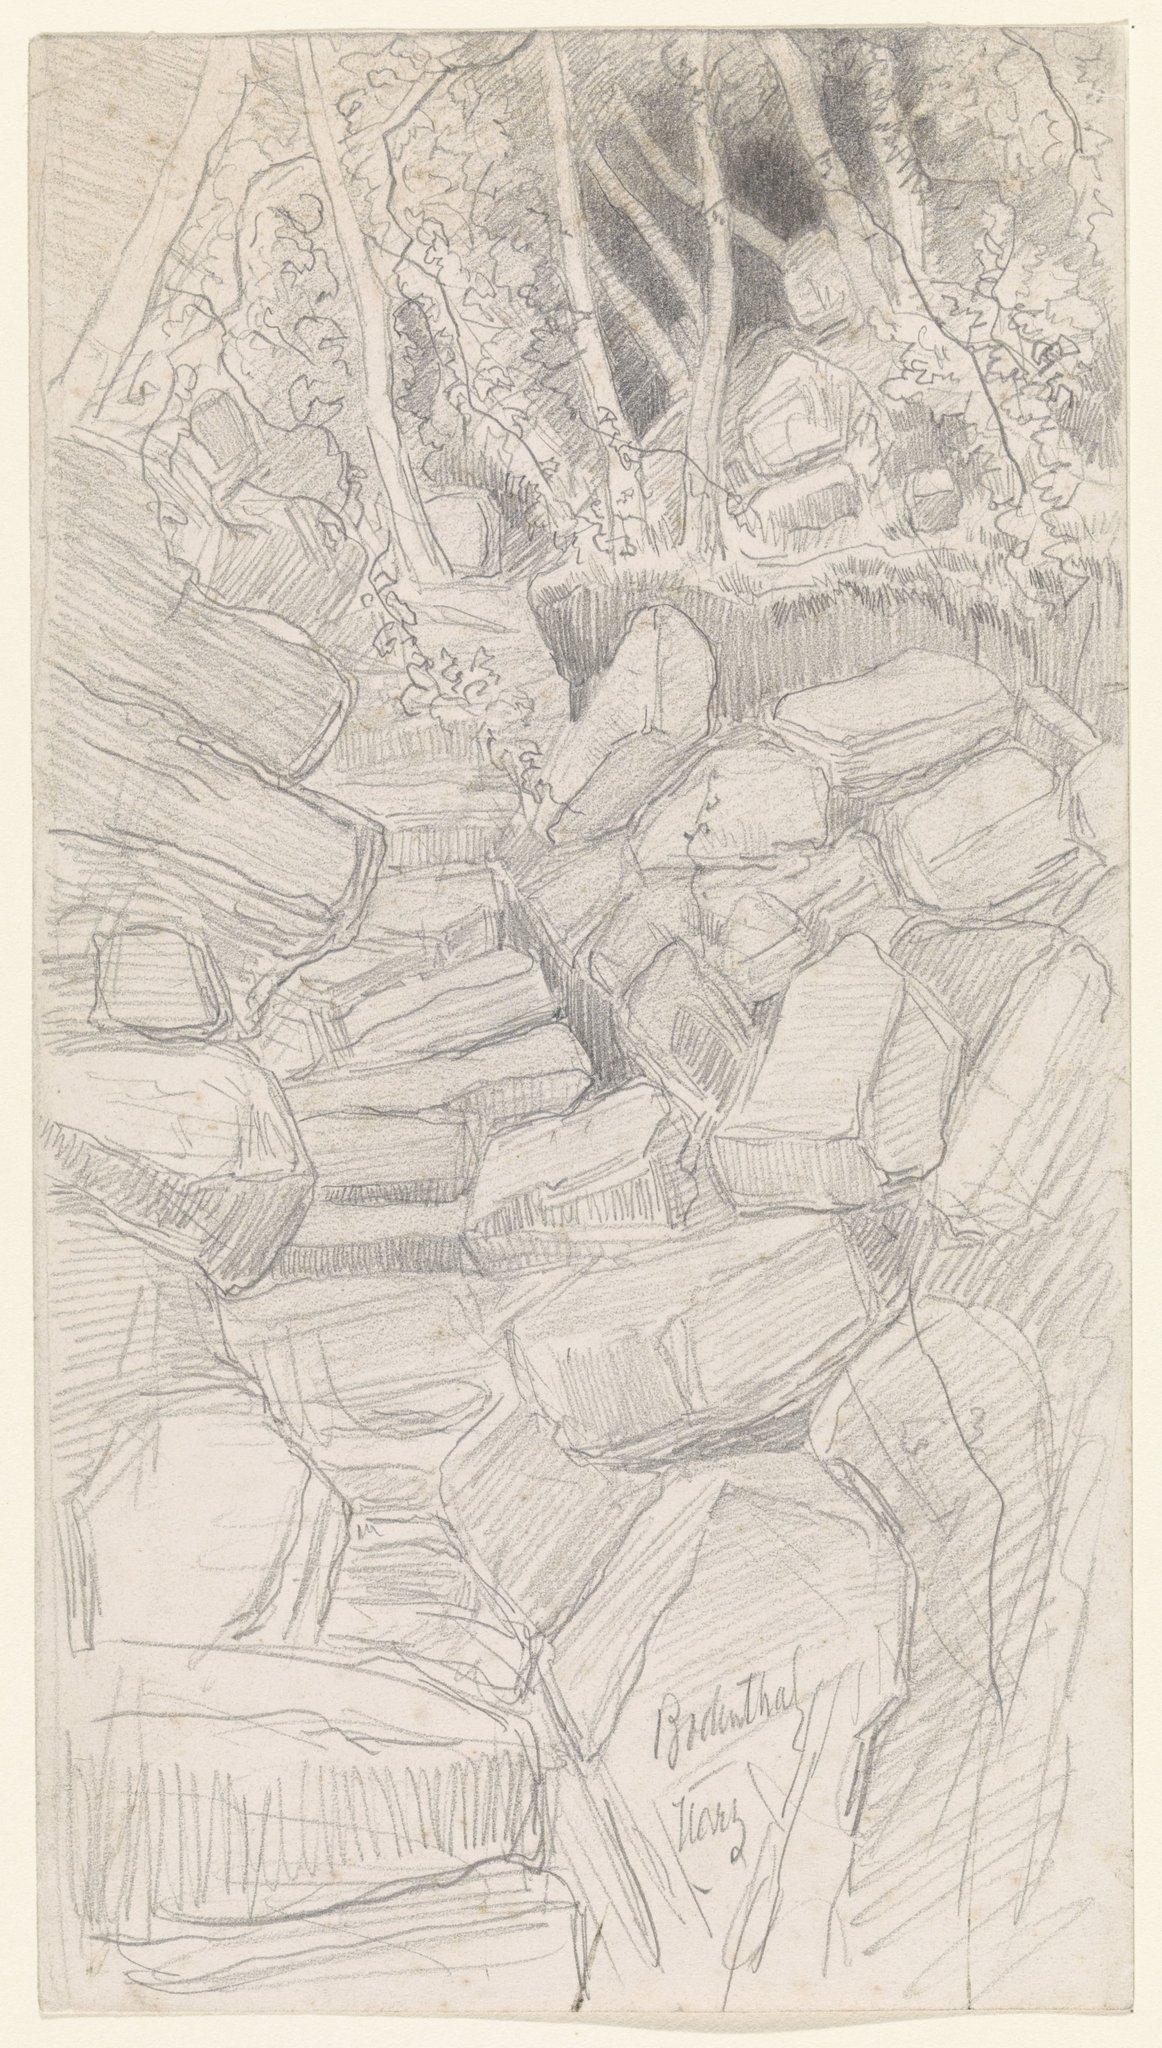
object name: drawing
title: Rotshelling in de Bodenthal, de Harz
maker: jan van essen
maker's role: draughtsman, print maker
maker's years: 1854-1936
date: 1864-1936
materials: paper, pencil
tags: landscapes in the temperate zone